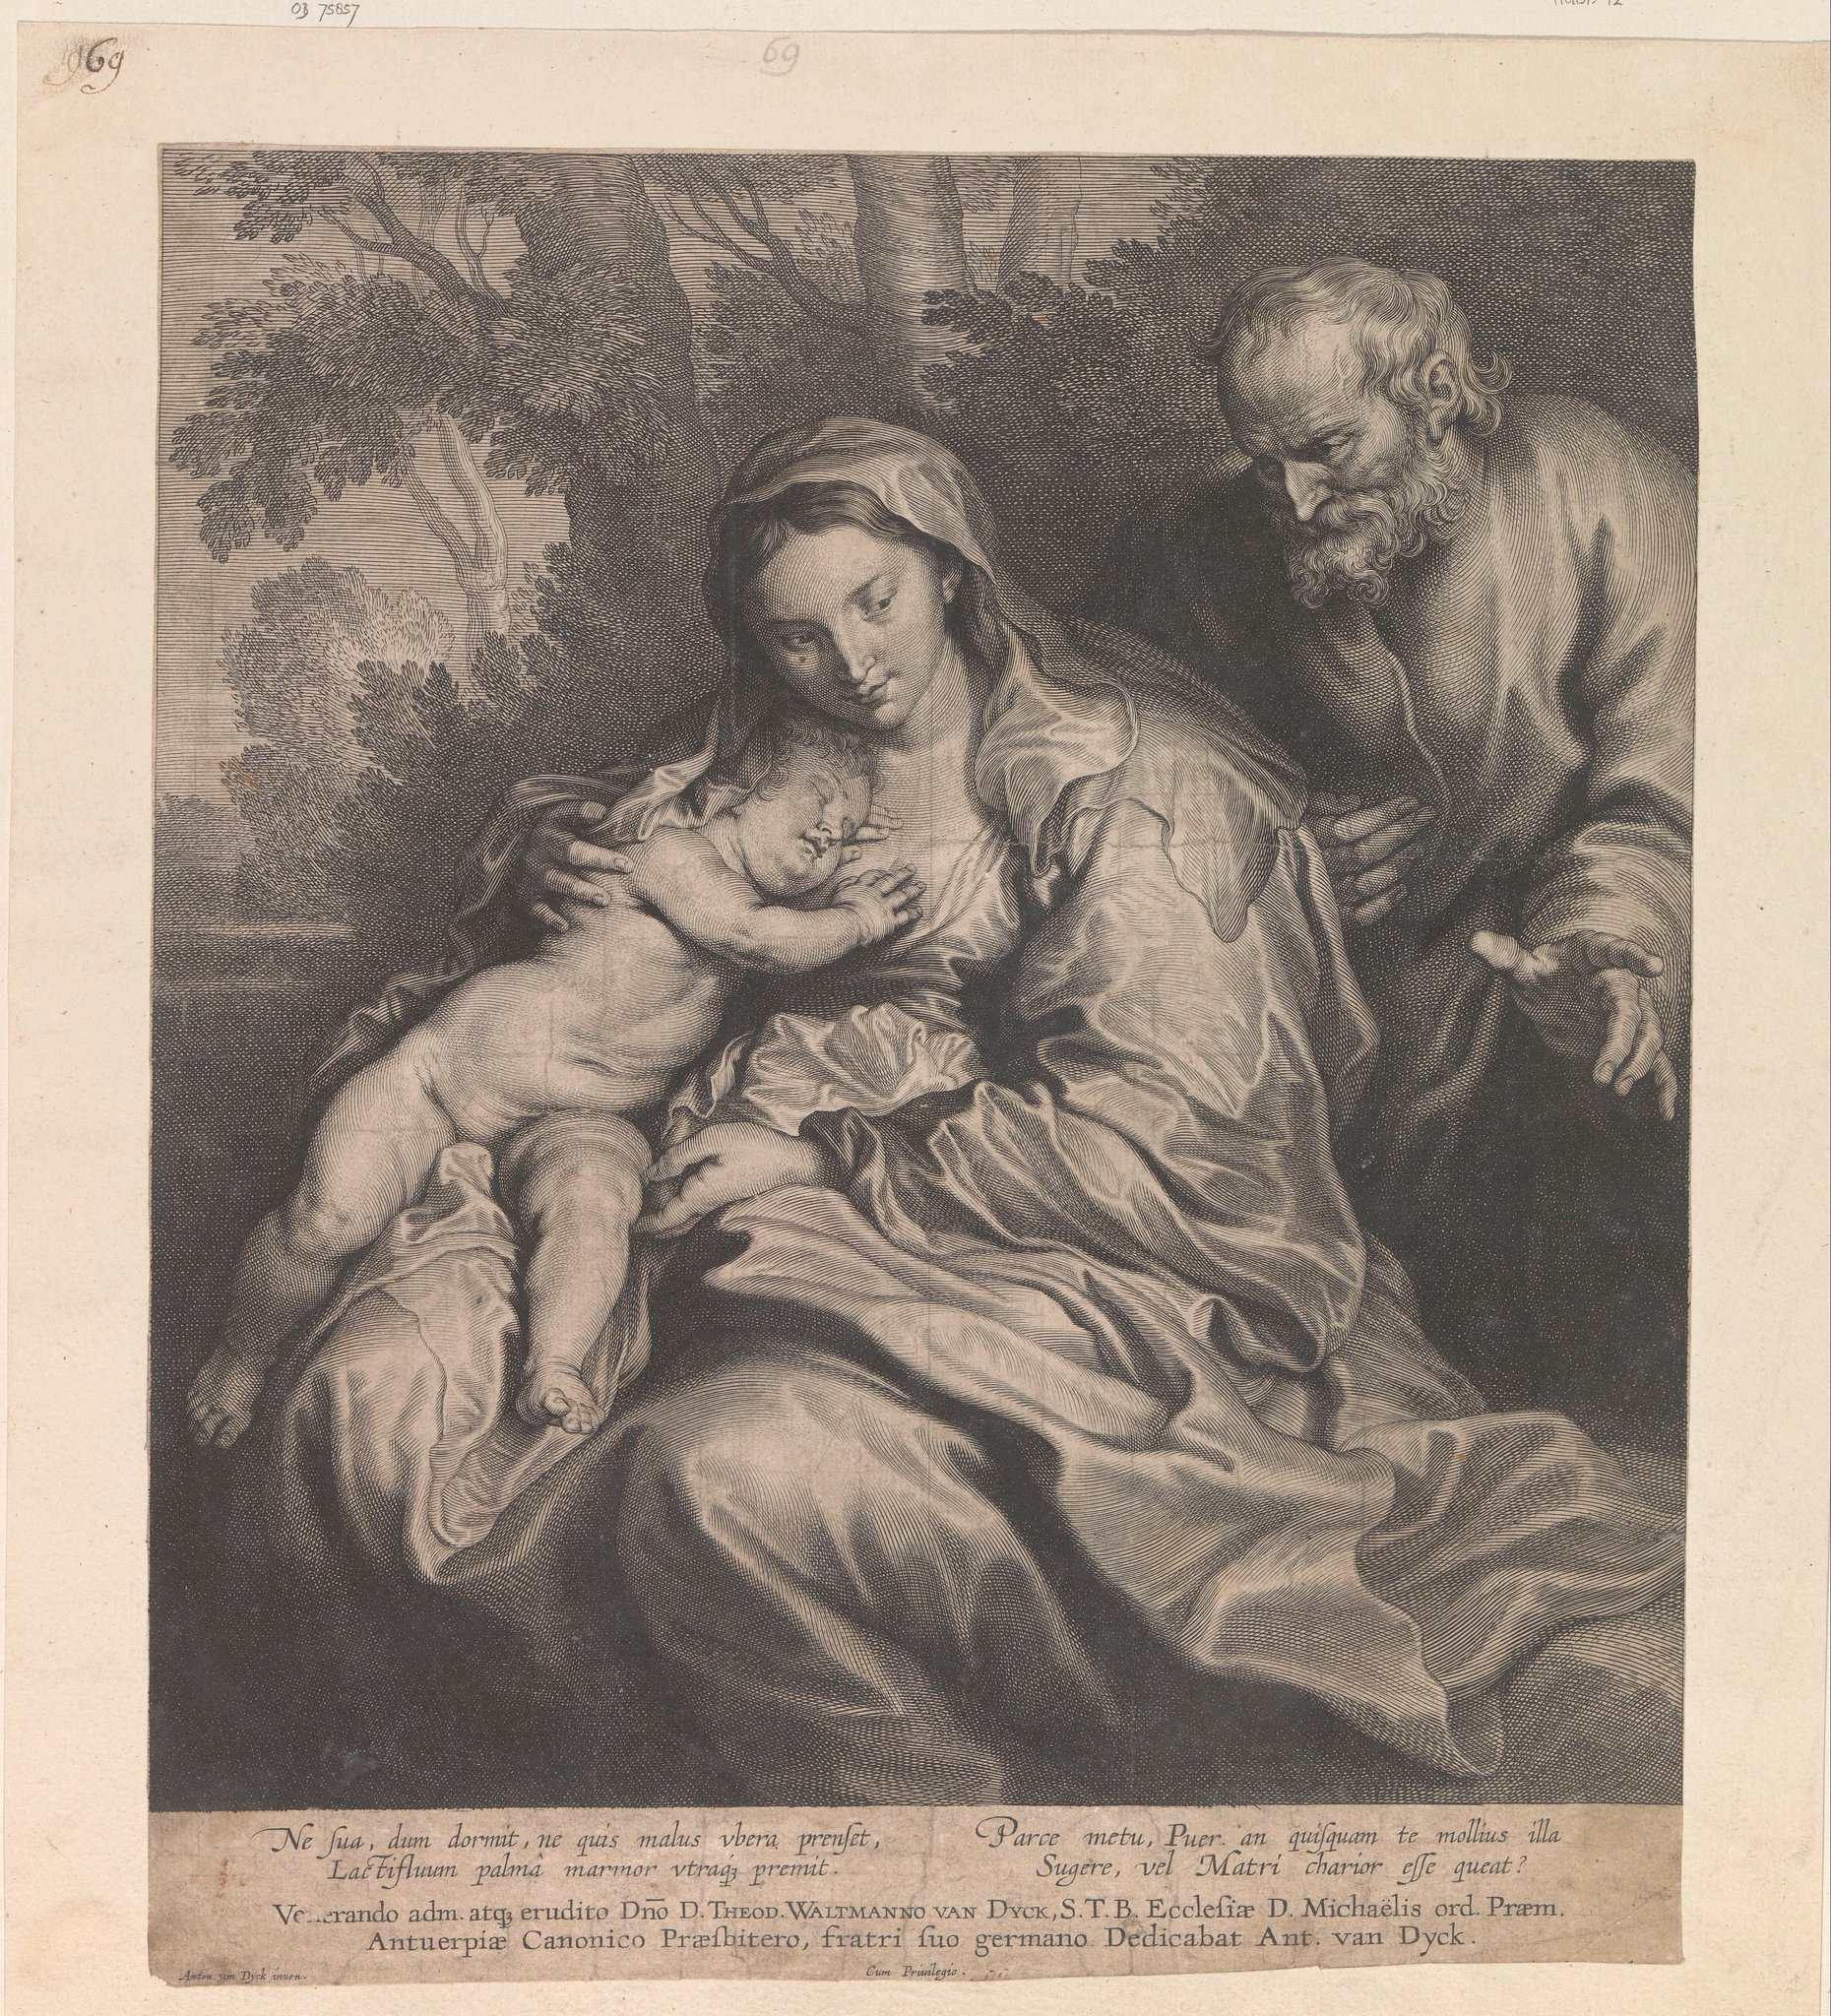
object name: print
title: De heilige familie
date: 1596-1659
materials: paper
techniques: engraving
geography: antwerp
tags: holy family, and derived representations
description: Heilige Familie rust tijdens de vlucht naar Egypte. Onder de voorstelling staat een vers in Latijn. Deze prent maakt deel uit van een album.